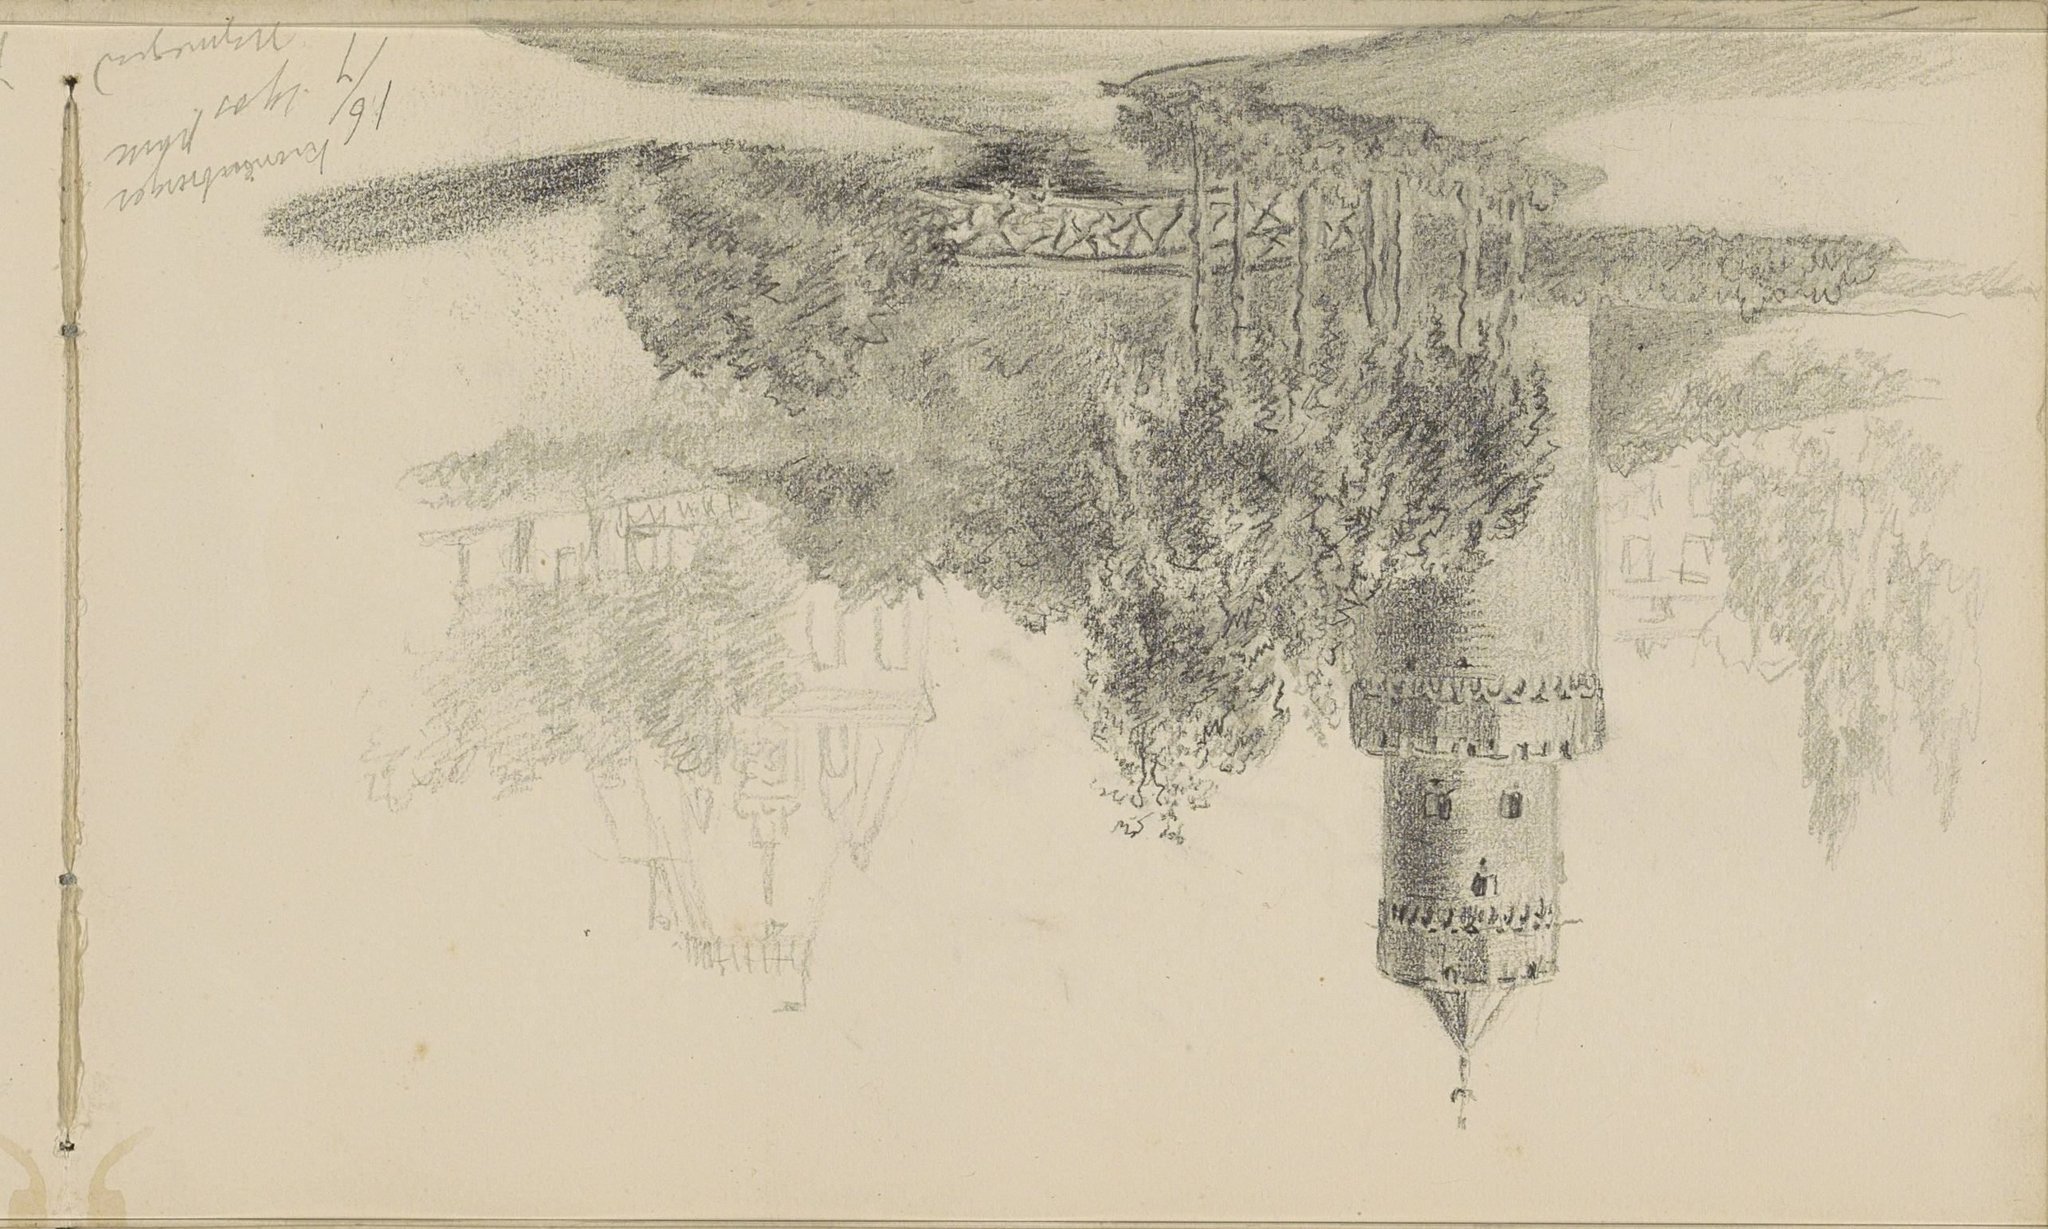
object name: sketchbook leaf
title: Kronenburgerpark met de Kruittoren te Nijmegen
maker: anna catharina maria van eeghen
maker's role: draughtsman, print maker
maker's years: 1878-1924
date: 1901-1907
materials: paper, pencil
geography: nijmegen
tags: park, towers ~ fortified city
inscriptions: date and inscription: ‘Kronenburger/ park/ 16/7 1901/ Nijmegen’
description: Blad 15 recto uit een schetsboek met 33 bladen.